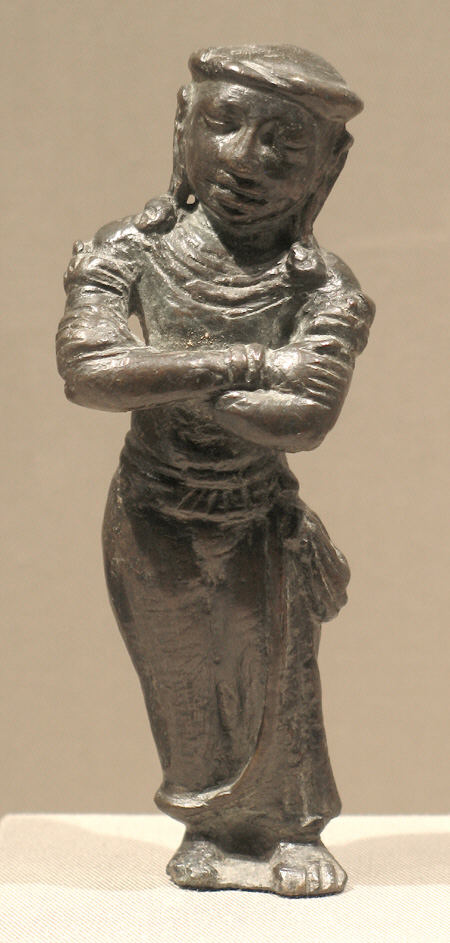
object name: figure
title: Standing Male Figure , Probably Chakrapurusha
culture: indian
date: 501-600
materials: bronze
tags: post-gupta,men